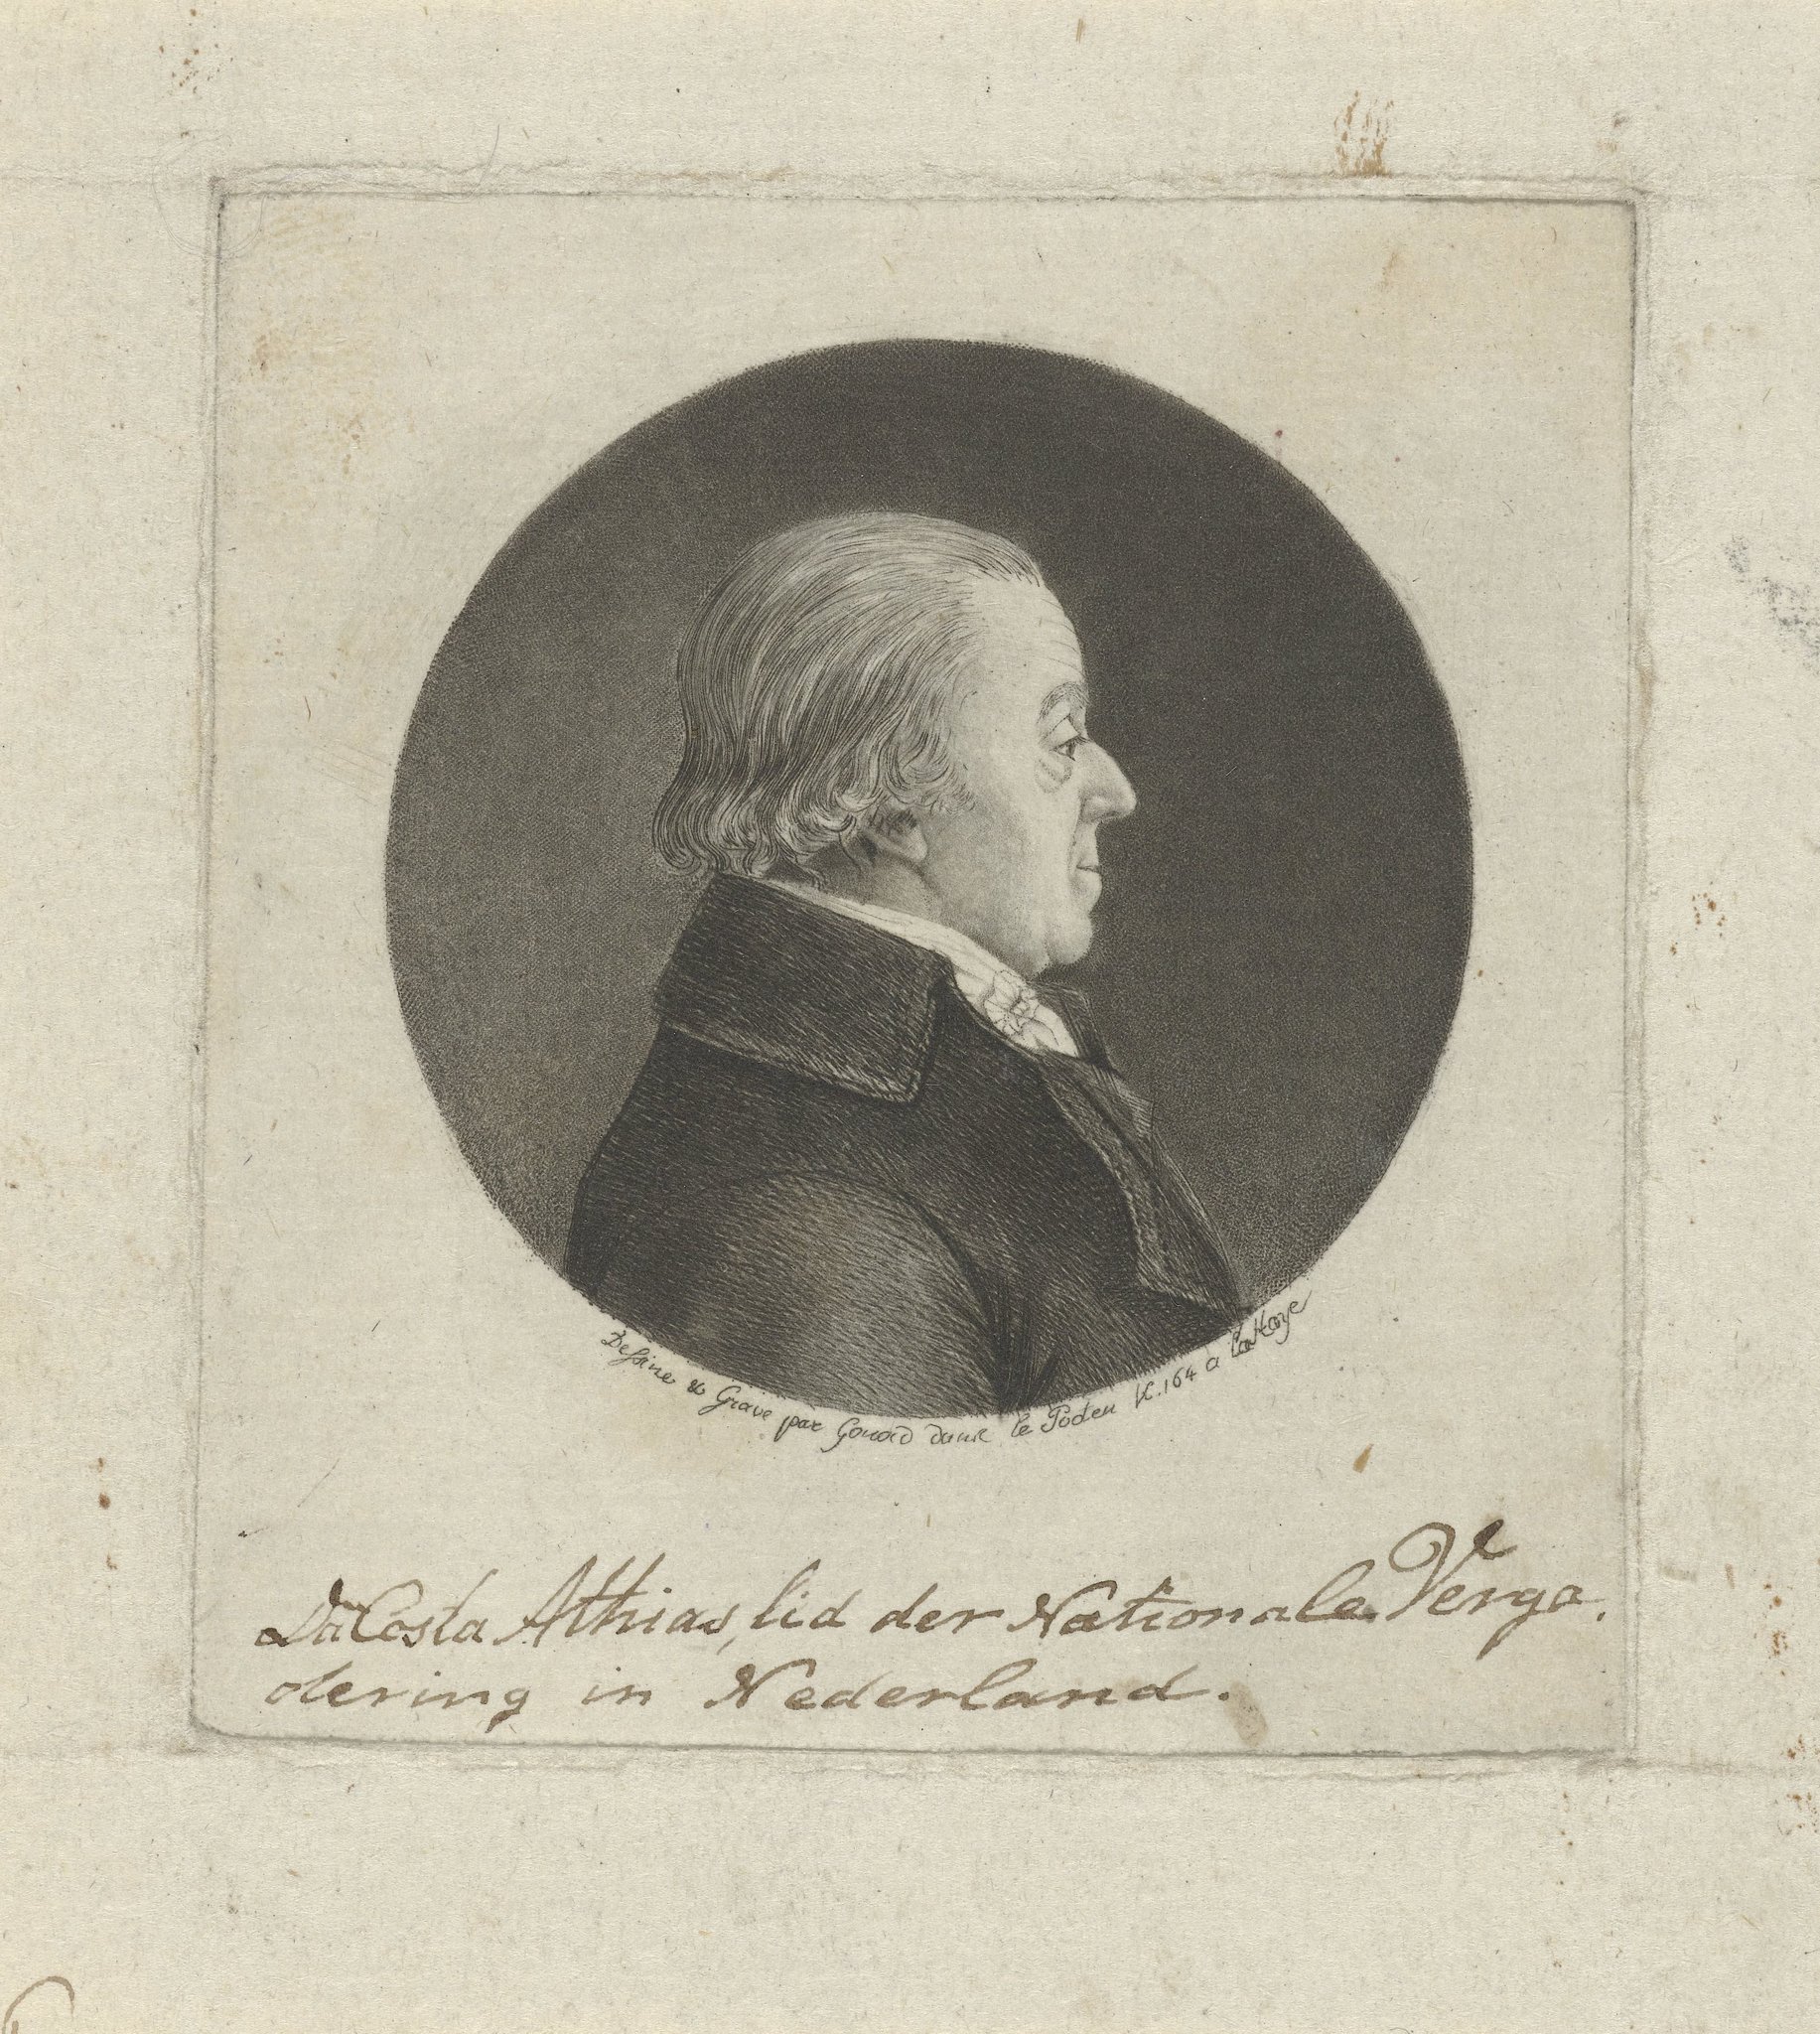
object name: physionotrace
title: Portret van Isaac da Costa Athias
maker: françois gonord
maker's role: print maker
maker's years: 1756-1825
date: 1794-1800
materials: paper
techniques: engraving, etching, roulette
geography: the hague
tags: amsterdam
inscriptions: caption: ‘DaCosta Athias lid der nationale Vergadering in Nederland’, collector's mark: Lugt 2228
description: Portret in een ronde lijst van Isaac da Costa Athias, een Amsterdamse koopman die tussen 1798 en 1800 lid was van het Vertegenwoordigend Lichaam voor het district Amsterdam. In profiel, buste naar rechts.